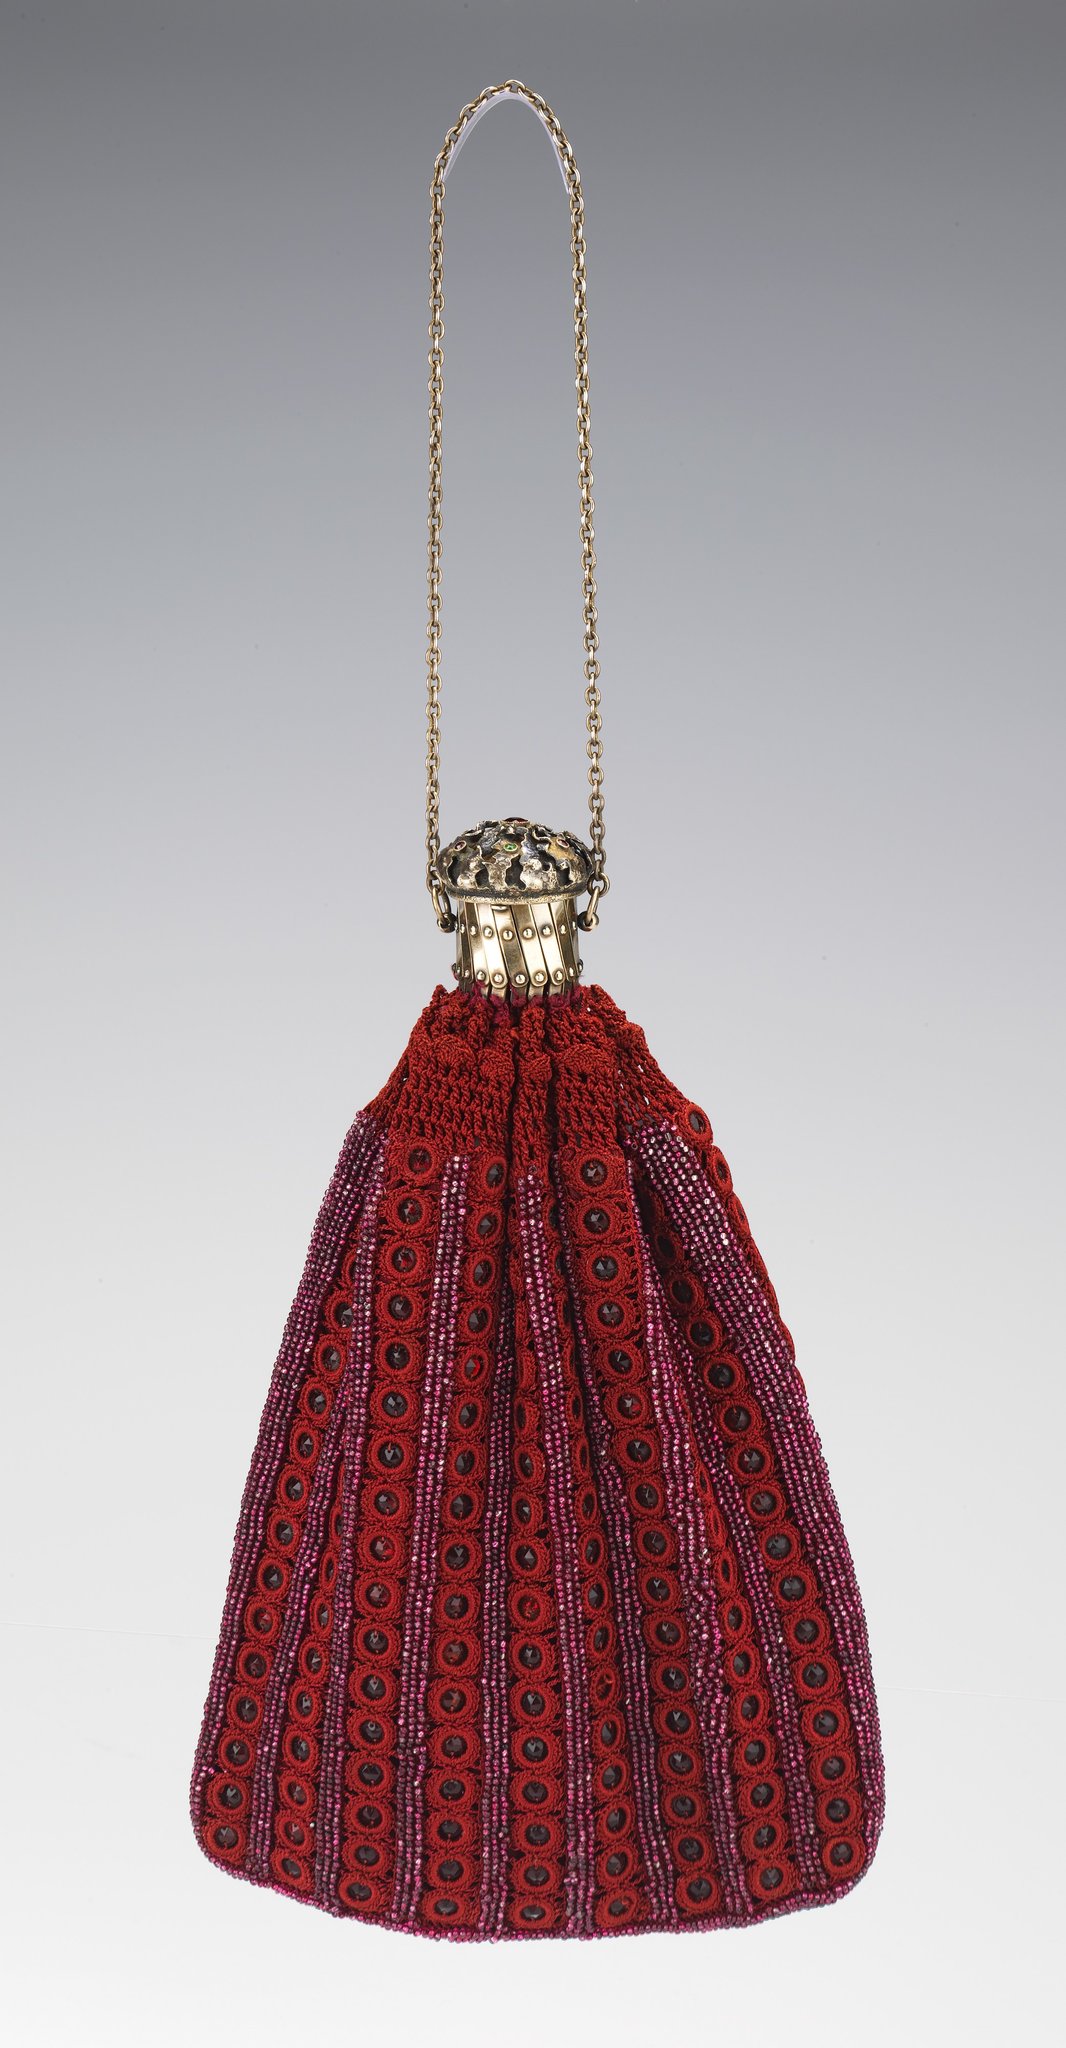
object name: bag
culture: american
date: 1851-1875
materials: metal, silk